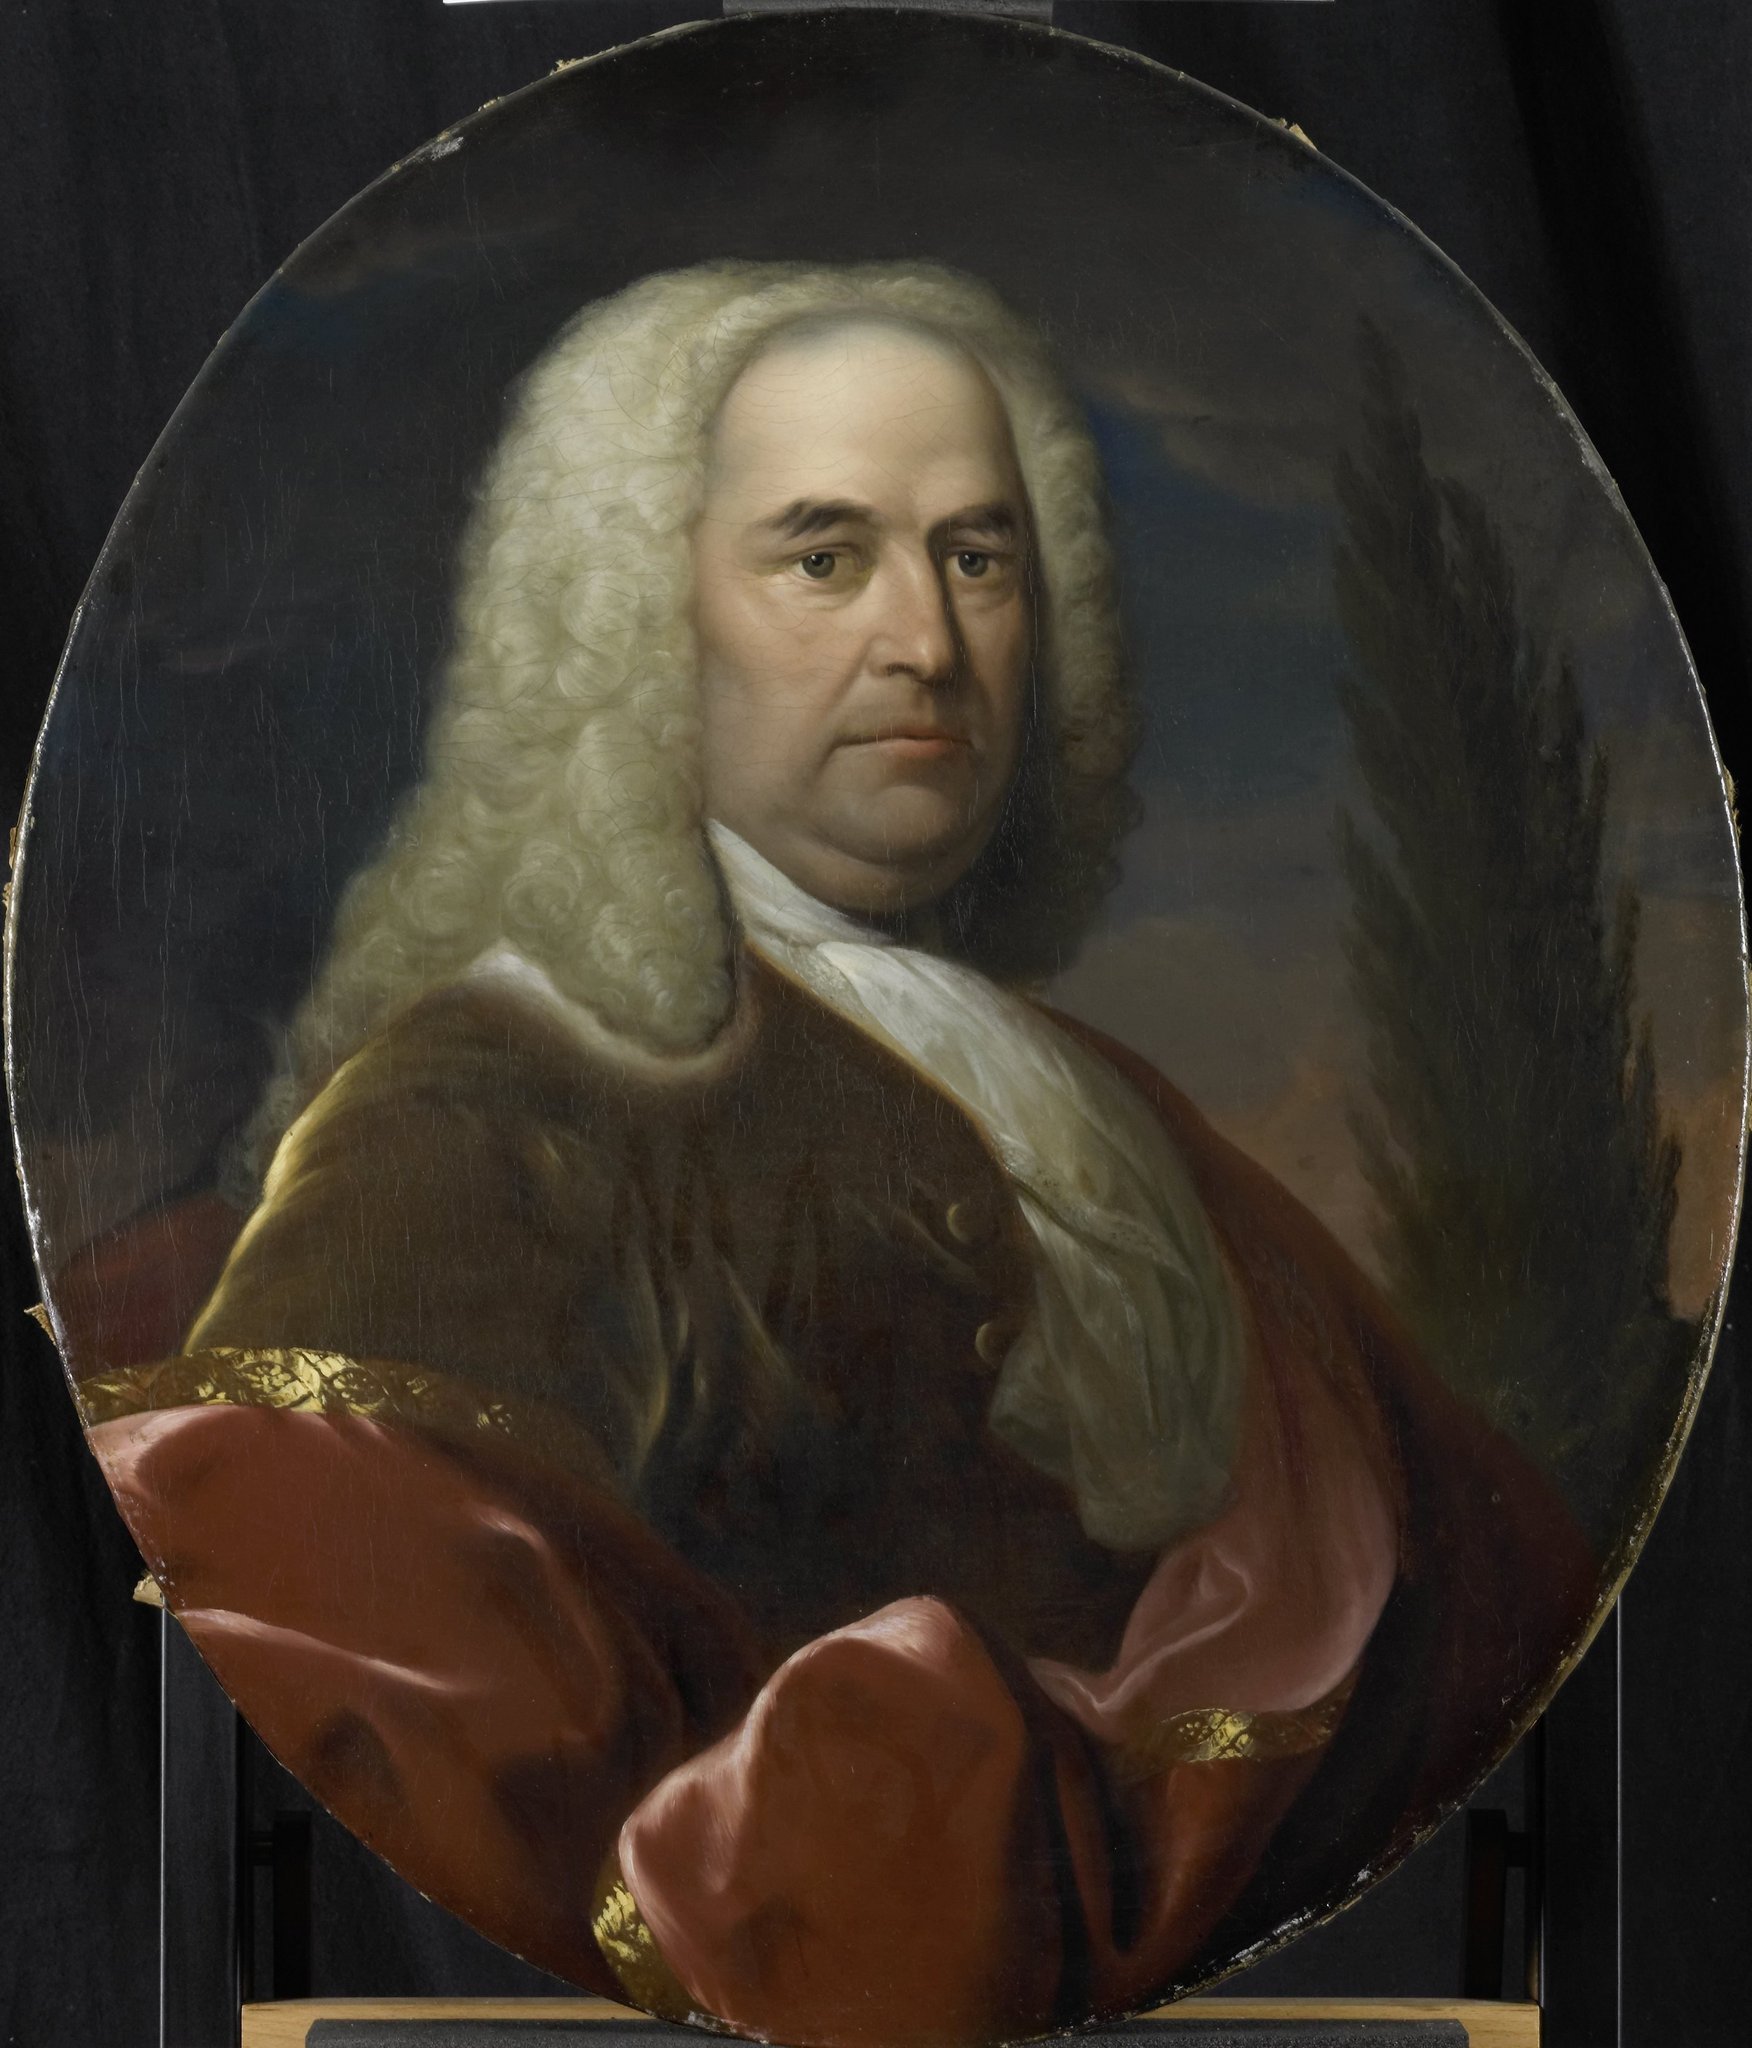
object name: painting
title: Portrait of Hugo du Bois, Director of the Rotterdam Chamber of the Dutch East India Company, elected 1734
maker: dionys van nijmegen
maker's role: draughtsman, painter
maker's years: 1705-1798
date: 1734-1798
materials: canvas, oil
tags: rotterdam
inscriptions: inscription: ‘17 Hugo du Bois. 34’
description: Portret van Hugo du Bois, gekozen in 1734. Buste in ovaal naar rechts. Onderdeel van een reeks portretten van de bewindhebbers van de Rotterdamse Kamer van de Verenigde Oost-Indische Compagnie, vervaardigd voor het Nieuw Oost-Indisch Huis uit 1698 aan de Boompjes te Rotterdam.